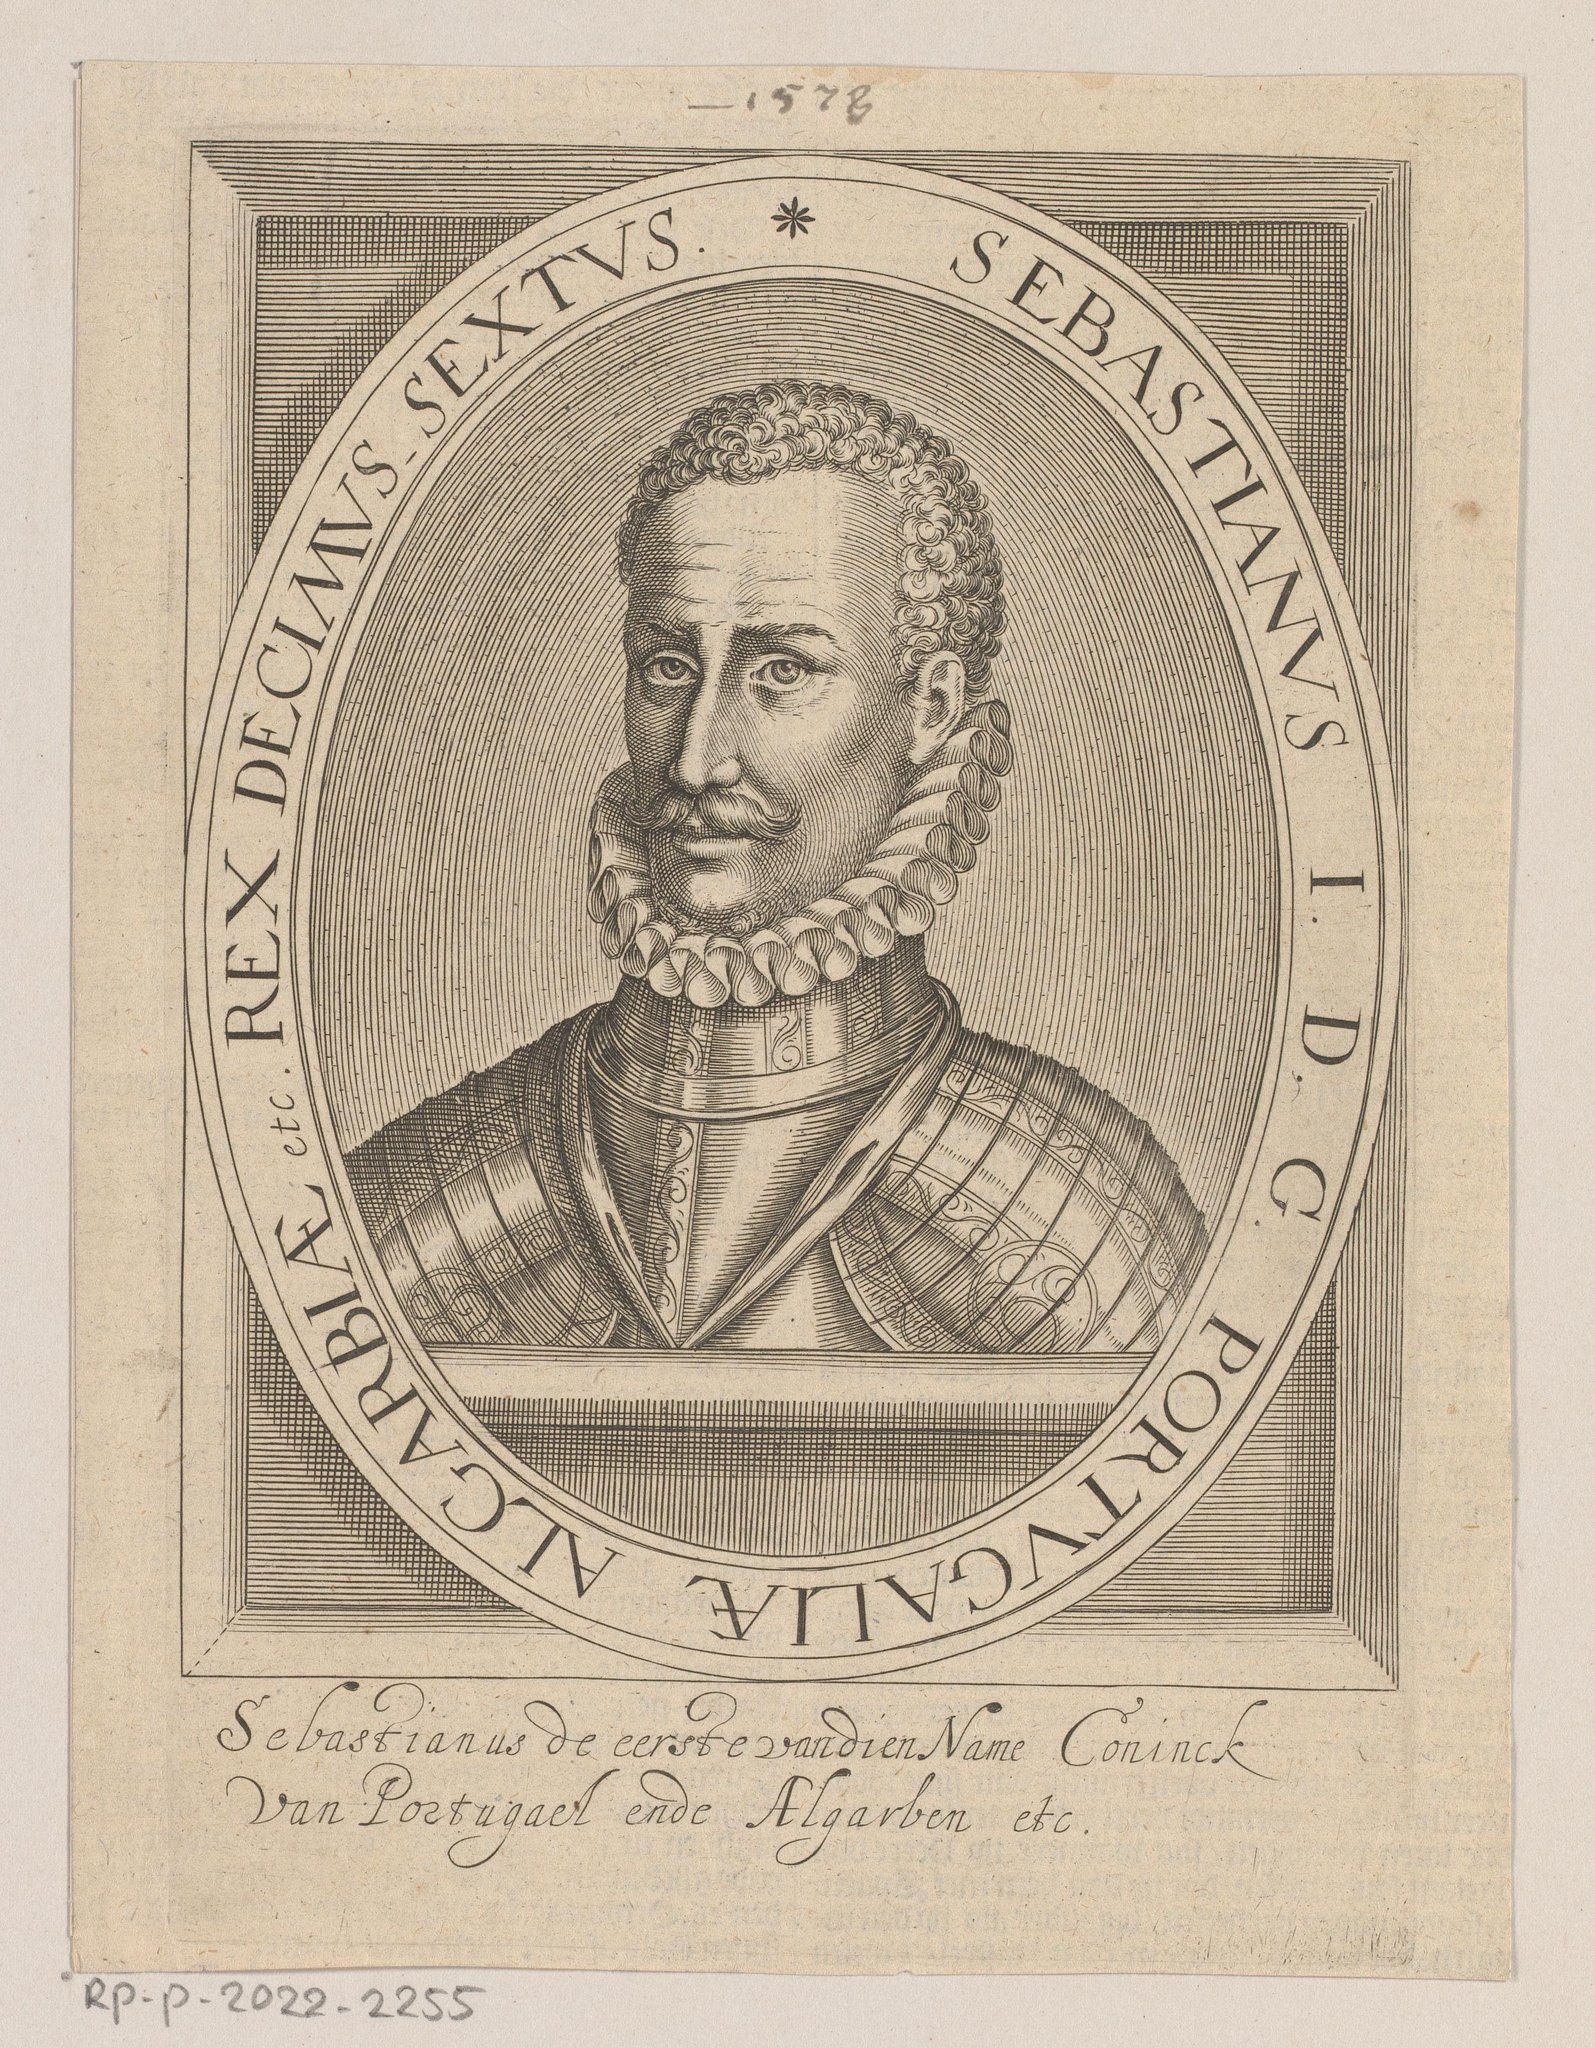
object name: print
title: Portret van Sebastiaan I van Portugal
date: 1614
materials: paper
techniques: engraving, letterpress printing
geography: the hague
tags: historical persons, king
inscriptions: number: ‘-1578’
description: Prent uit: Meteren, Emanuel van. Historie der Nederlandscher ende haerder na-buren oorlogen ende geschiedenissen (...). Den Haag: Hillebrant Jacobsz. van Wouw, 1614.